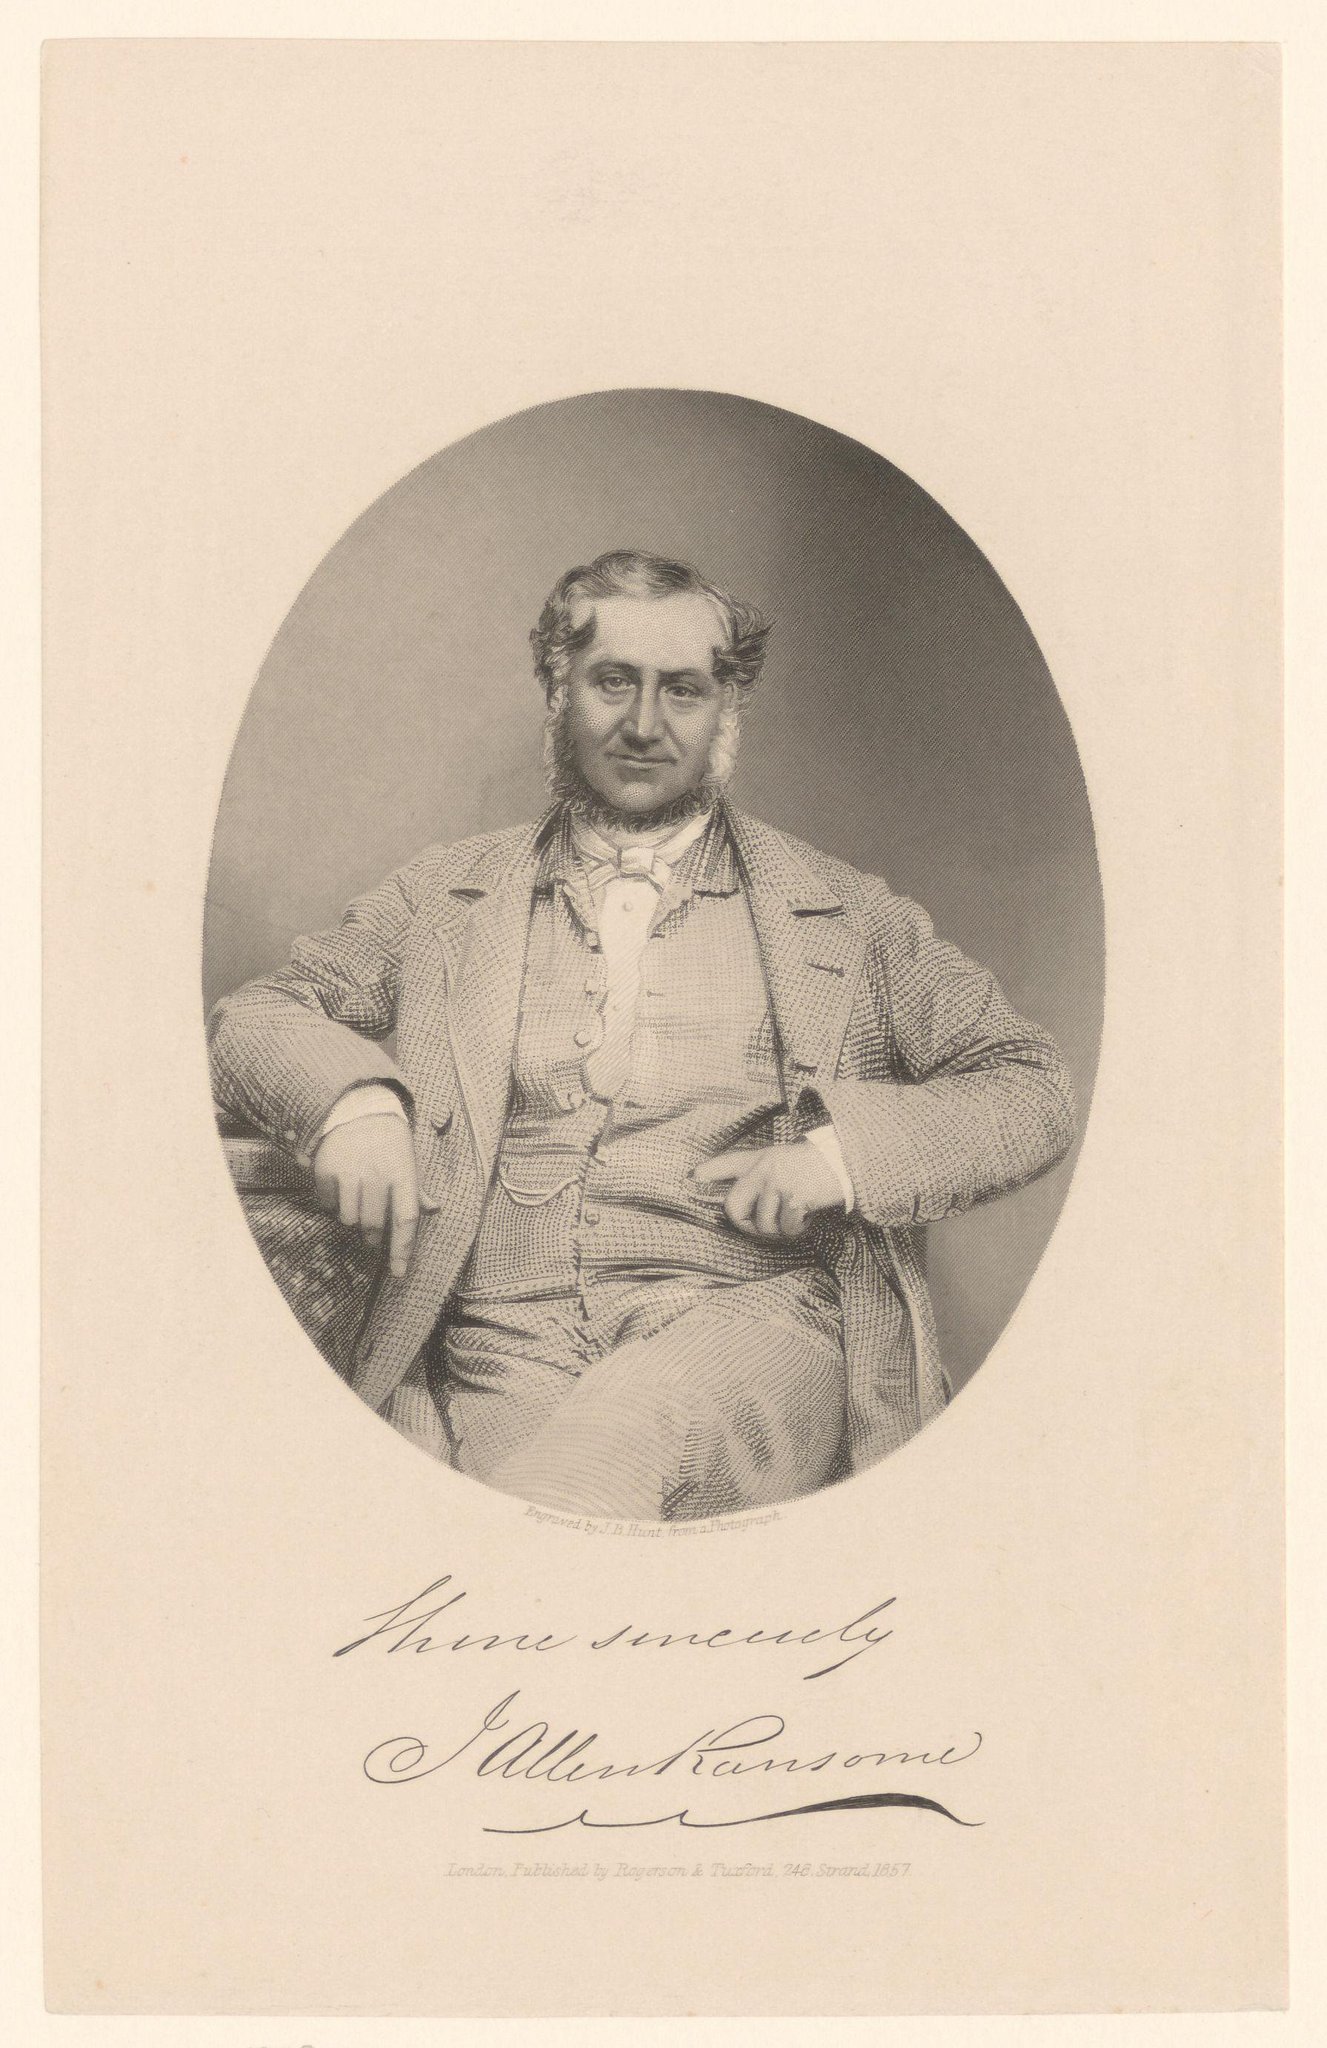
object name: print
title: Portret van James Allen Ransome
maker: j.b. hunt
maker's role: print maker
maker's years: 1842-1868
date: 1857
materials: paper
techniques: engraving, etching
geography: london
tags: engineer, historical persons, merchant, salesman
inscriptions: collector's mark: Lugt 2228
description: Een facsimile signatuur in de ondermarge.